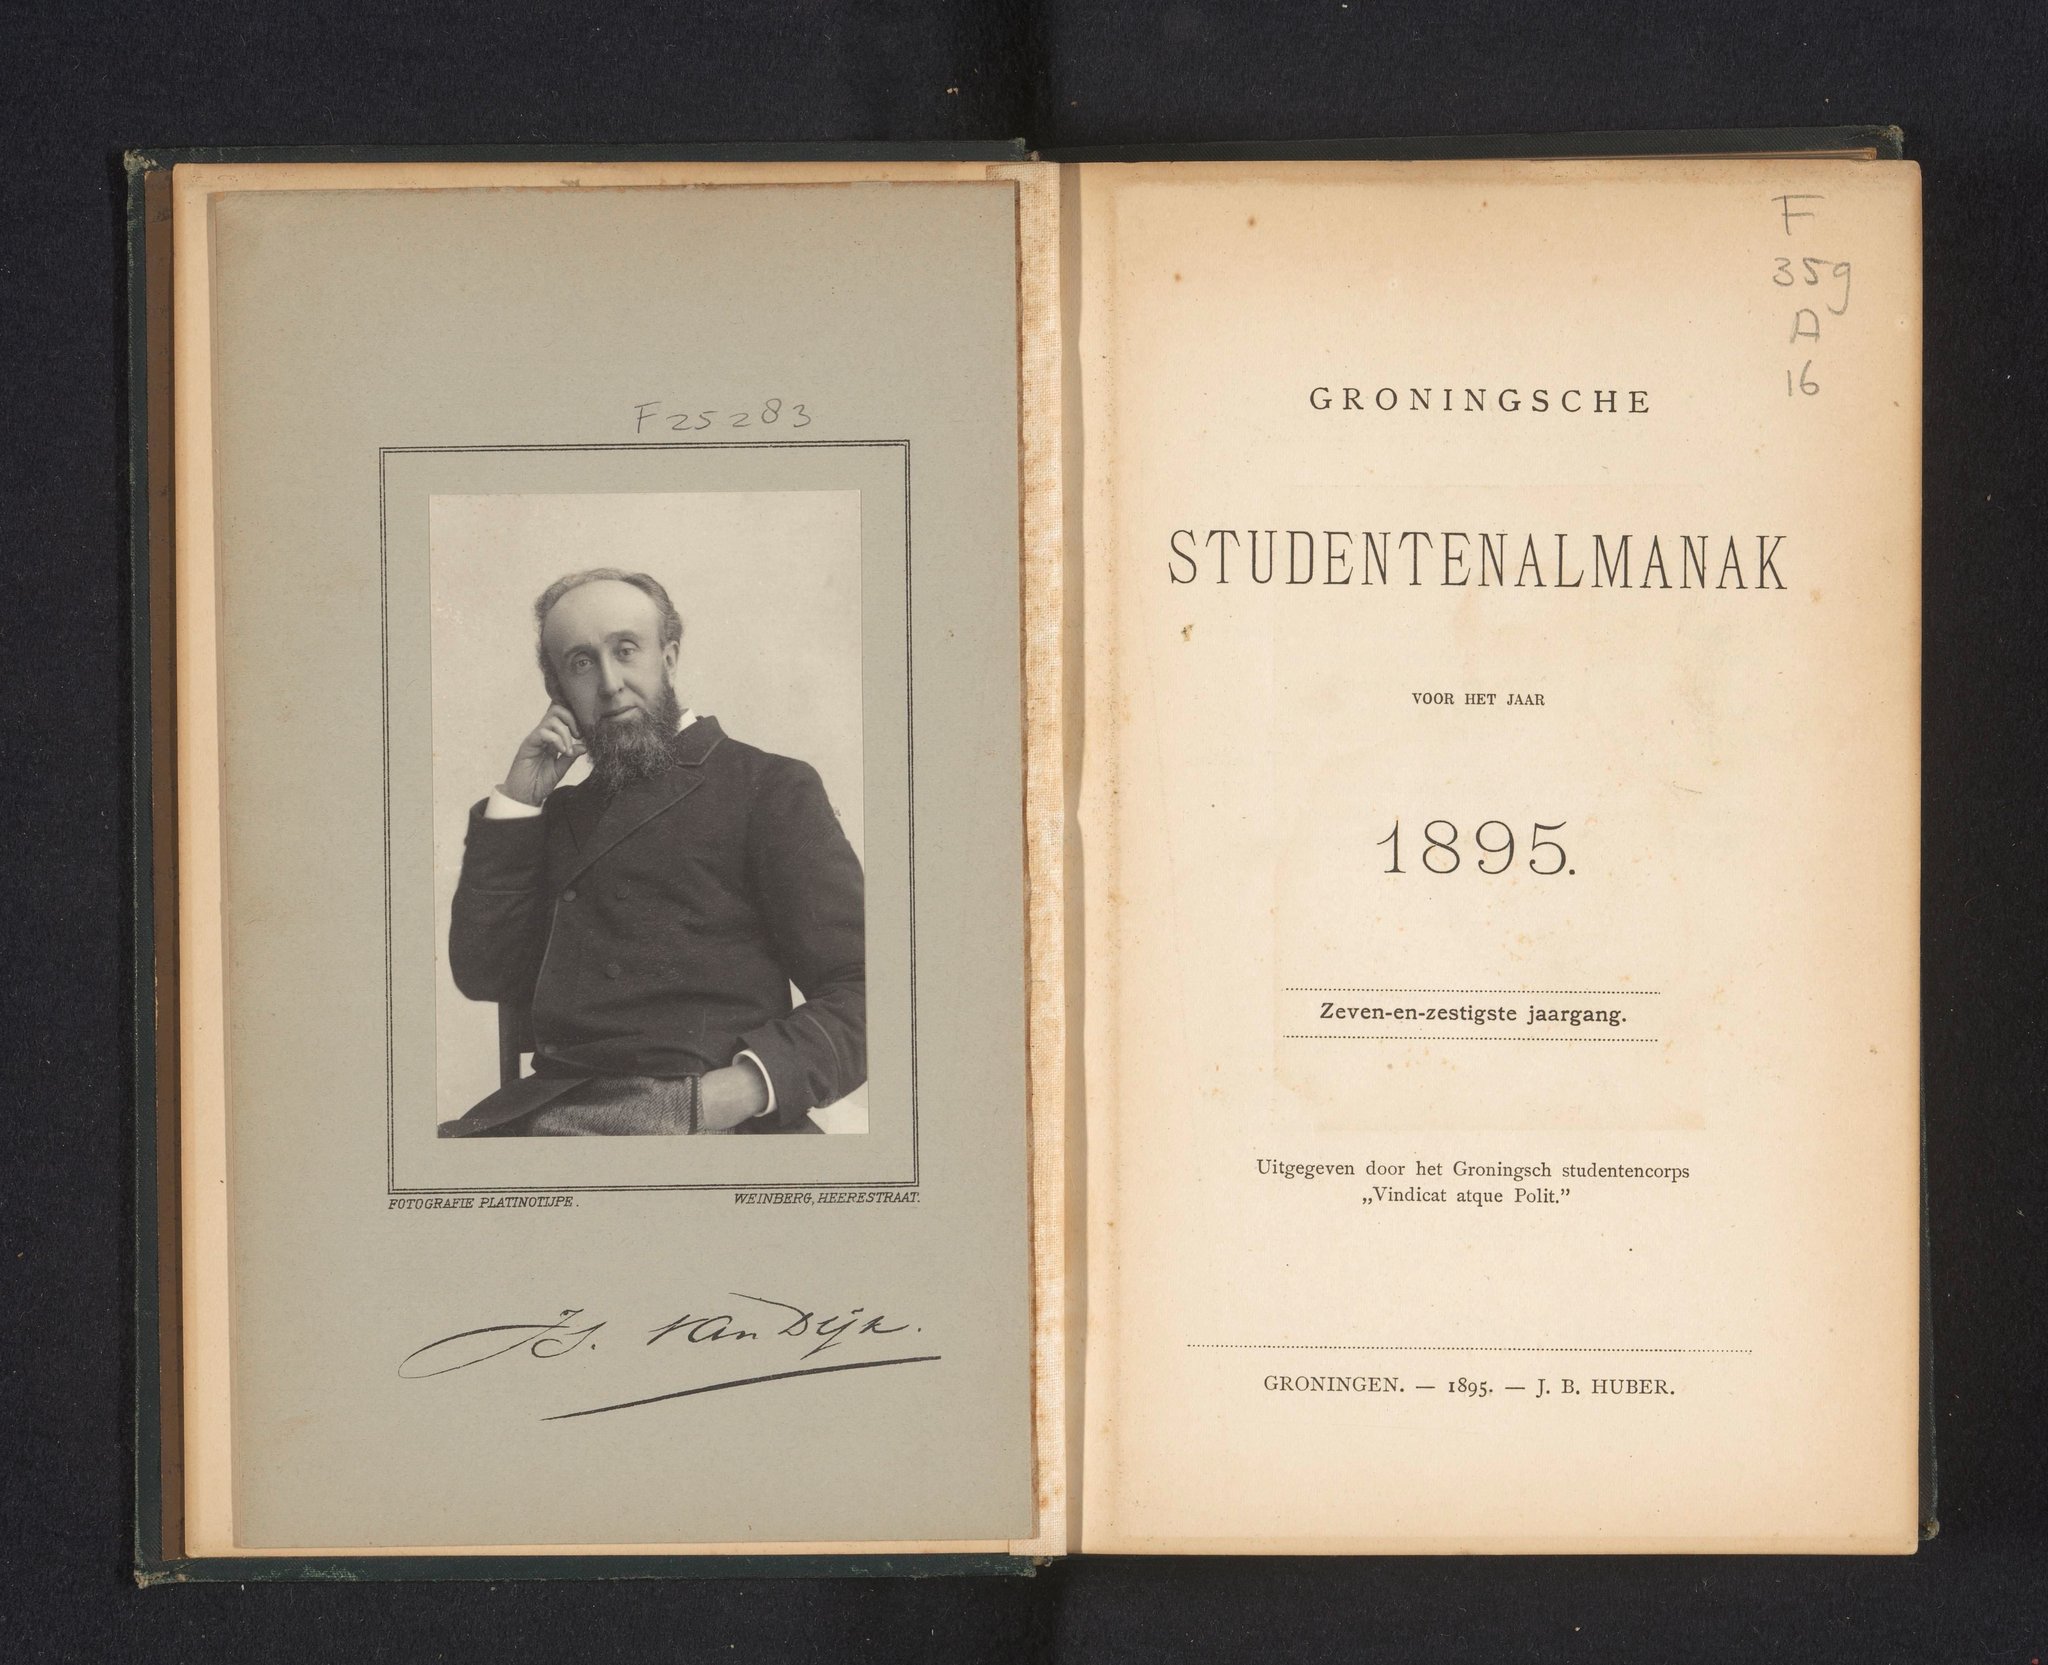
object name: book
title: Groninger studenten almanak voor het jaar 1895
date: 1895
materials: cardboard, linen, paper, photographic support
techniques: platinum process, printing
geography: groningen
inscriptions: annotation: ‘gekocht maart 19[..] f 1.50/ bij [...] Amsterdam’, name: ‘[...]’, annotation: ‘qt/ h-vv’